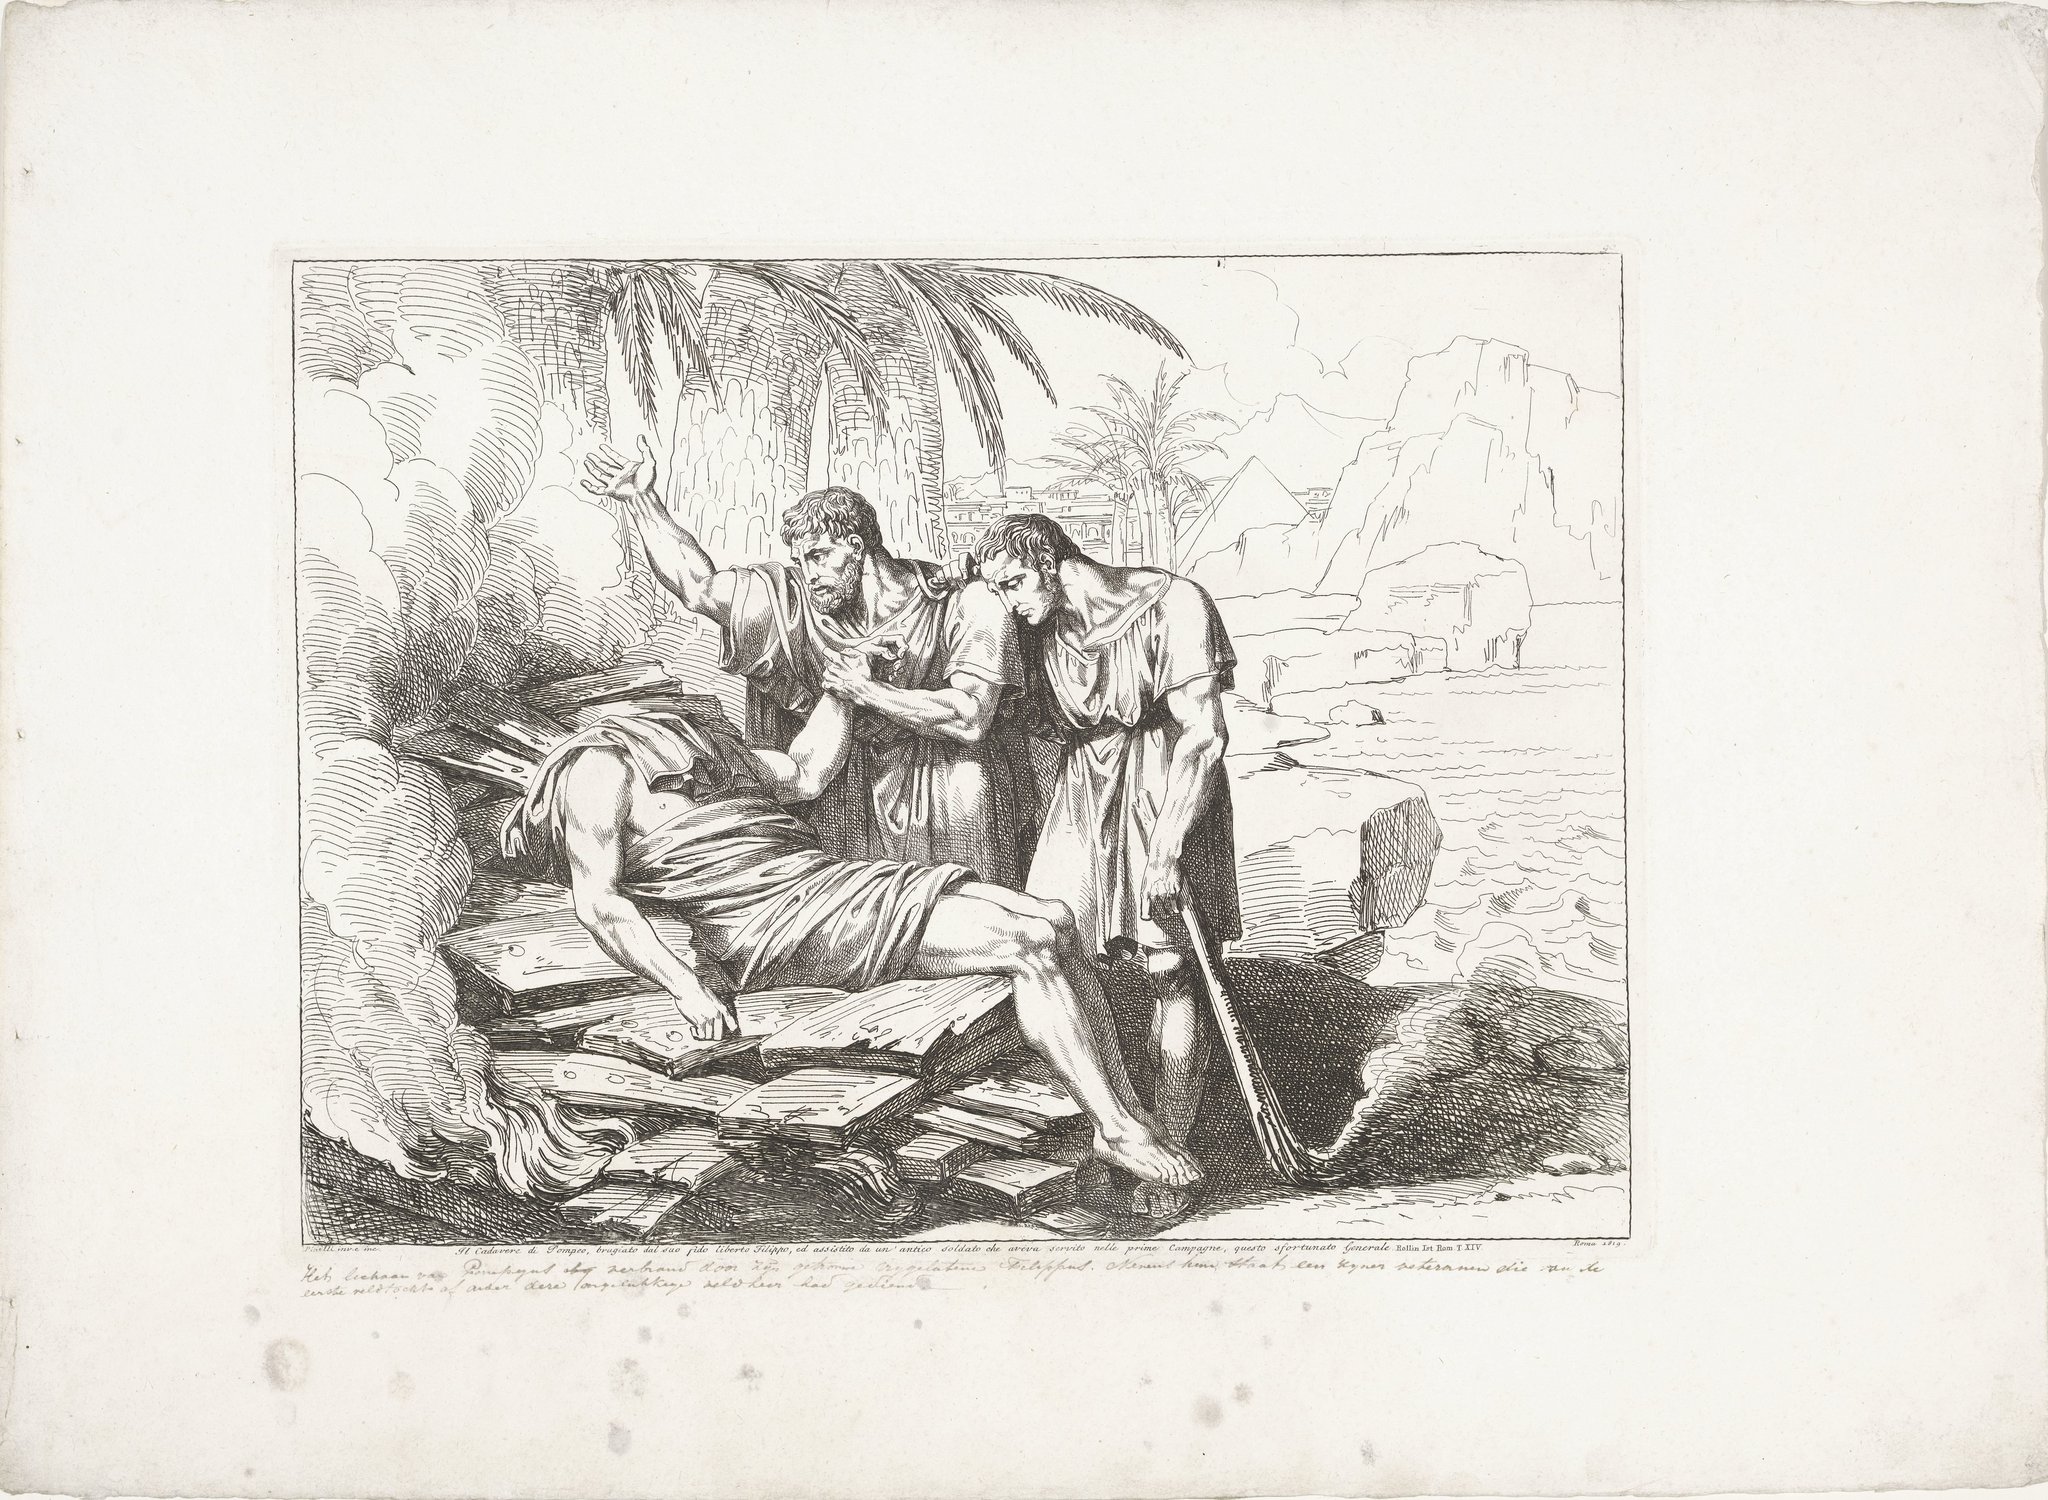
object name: print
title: Il Cadavere di Pompeo, brugiato dal suo fido liberto Filippo, ed assistito da un´ antico soldato che aveva servito nelle prime Campagne, questo sfortunato Generale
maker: bartolomeo pinelli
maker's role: draughtsman, print maker, sculptor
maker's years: 1781-1835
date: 1819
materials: paper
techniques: etching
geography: rome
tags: (story of) gnaeus pompeius magnus, pompey the great, body-burning, cremation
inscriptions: collector's mark: Lugt 2228, inscription: ‘Het lichaam van Pompejus verbrand door zijn getrouwe vrijgelatene Filippus....’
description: Deze prent maakt deel uit van een reeks van 101 prenten over de geschiedenis van Rome.